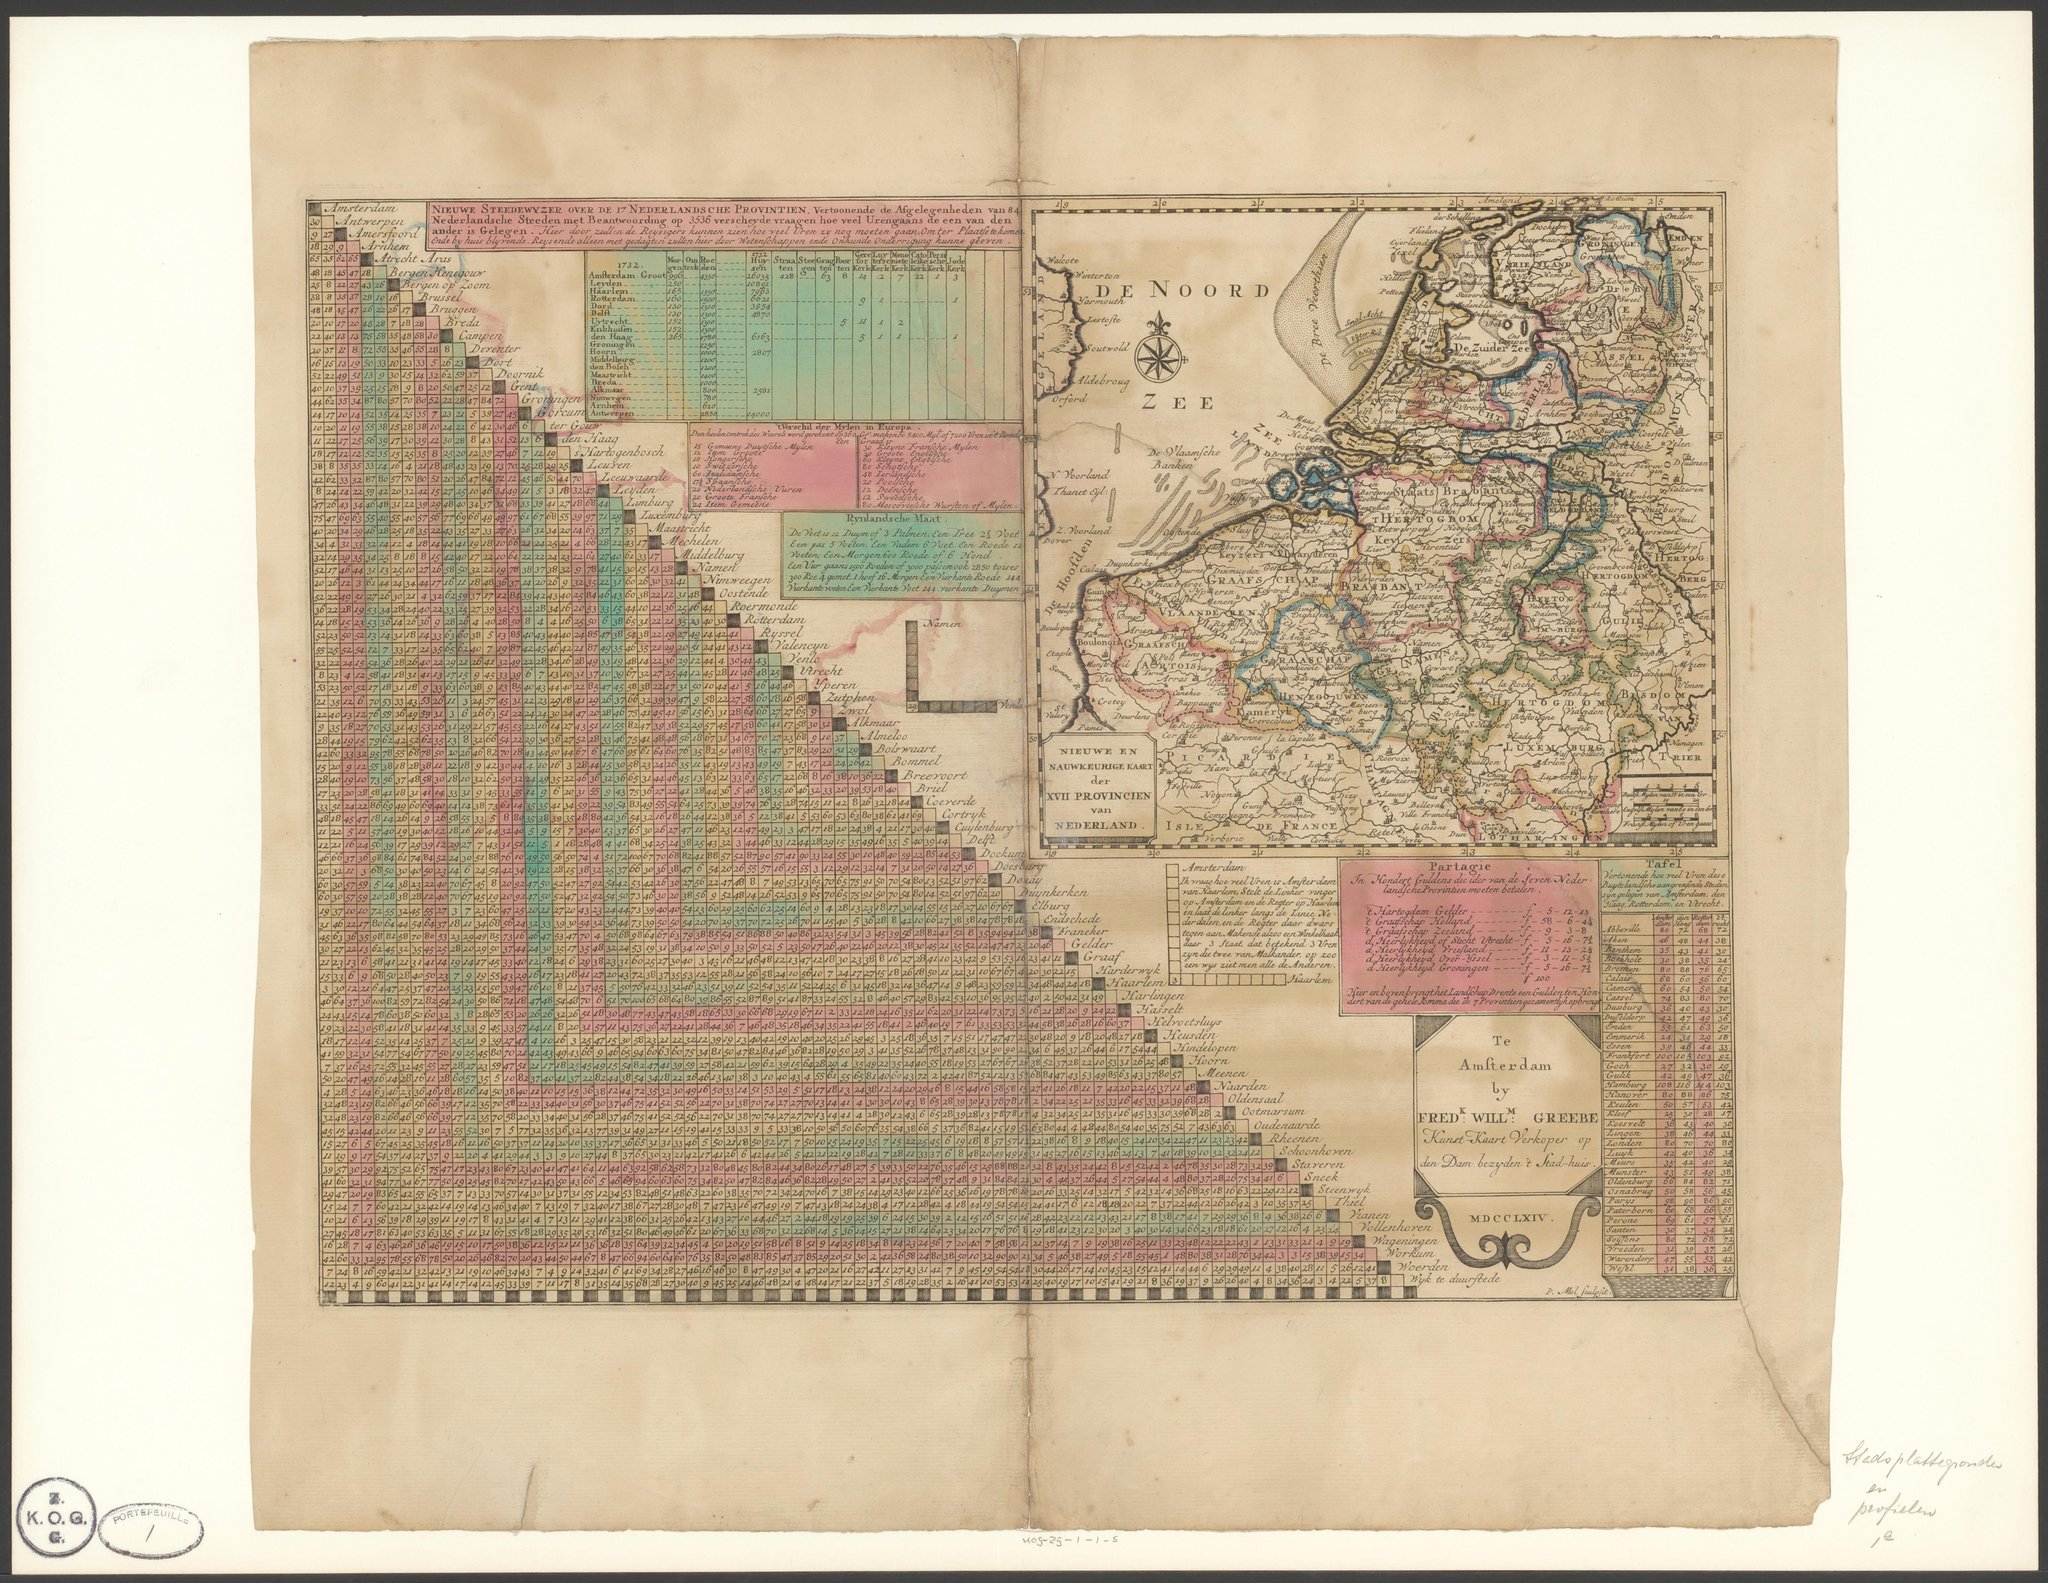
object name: national map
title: Afstandstabel tussen Nederlandse steden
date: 1764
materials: paper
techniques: etching, hand coloring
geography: amsterdam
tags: statistic diagram, graph; pictorial chart, etc., low countries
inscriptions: collector's mark: Lugt 1641, collector's mark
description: Afstandstabel met de afstanden tussen de voornaamste Nederlandse steden. Links het tabel, rechts een kaart van de zeventien Nederlandse provincies met kompasroos en enkele blokken met verschillende soorten informatie. Met een vouw door het midden, uit een boek genomen. Onderwerpsrubrieken binnen de Atlas Zeden en Gewoonten: topografie; stadsplattegronden.